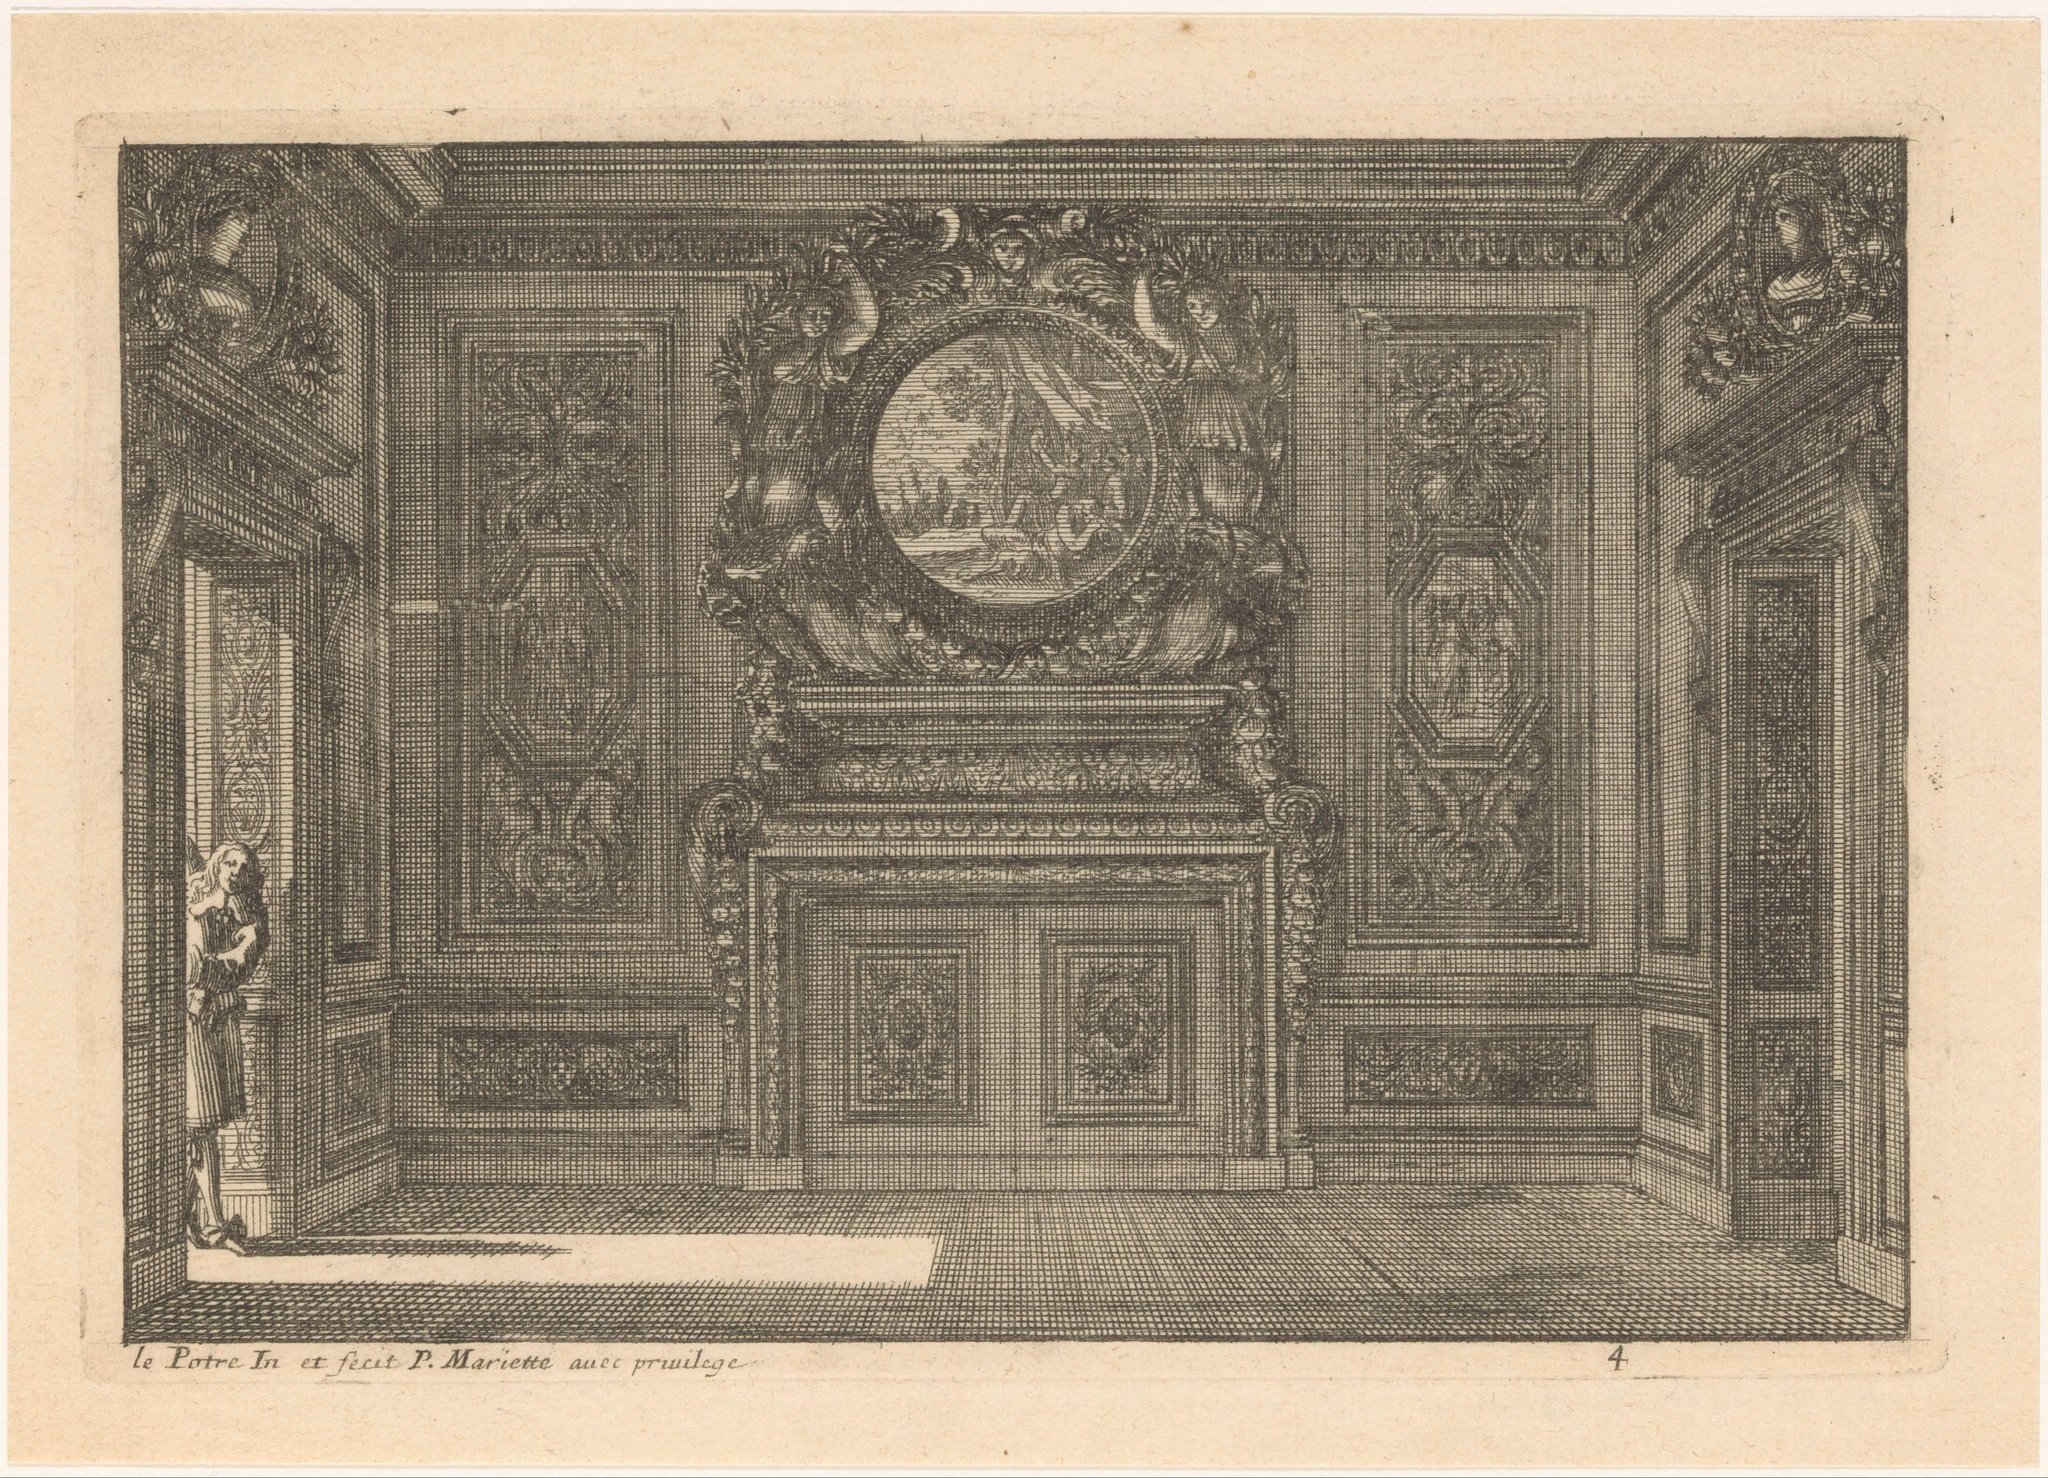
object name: print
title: Schouwen en houten lambriseringen in interieurs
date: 1658-1670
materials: paper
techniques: etching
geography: paris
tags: open hearth, fire-place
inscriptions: collector's mark: Lugt 2228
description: Kamer met schouw in het midden. De schoorsteenmantel is afgesloten met twee luiken. Daarboven een rond medaillon met een Bacchische scène. Links opent een bediende een deur.